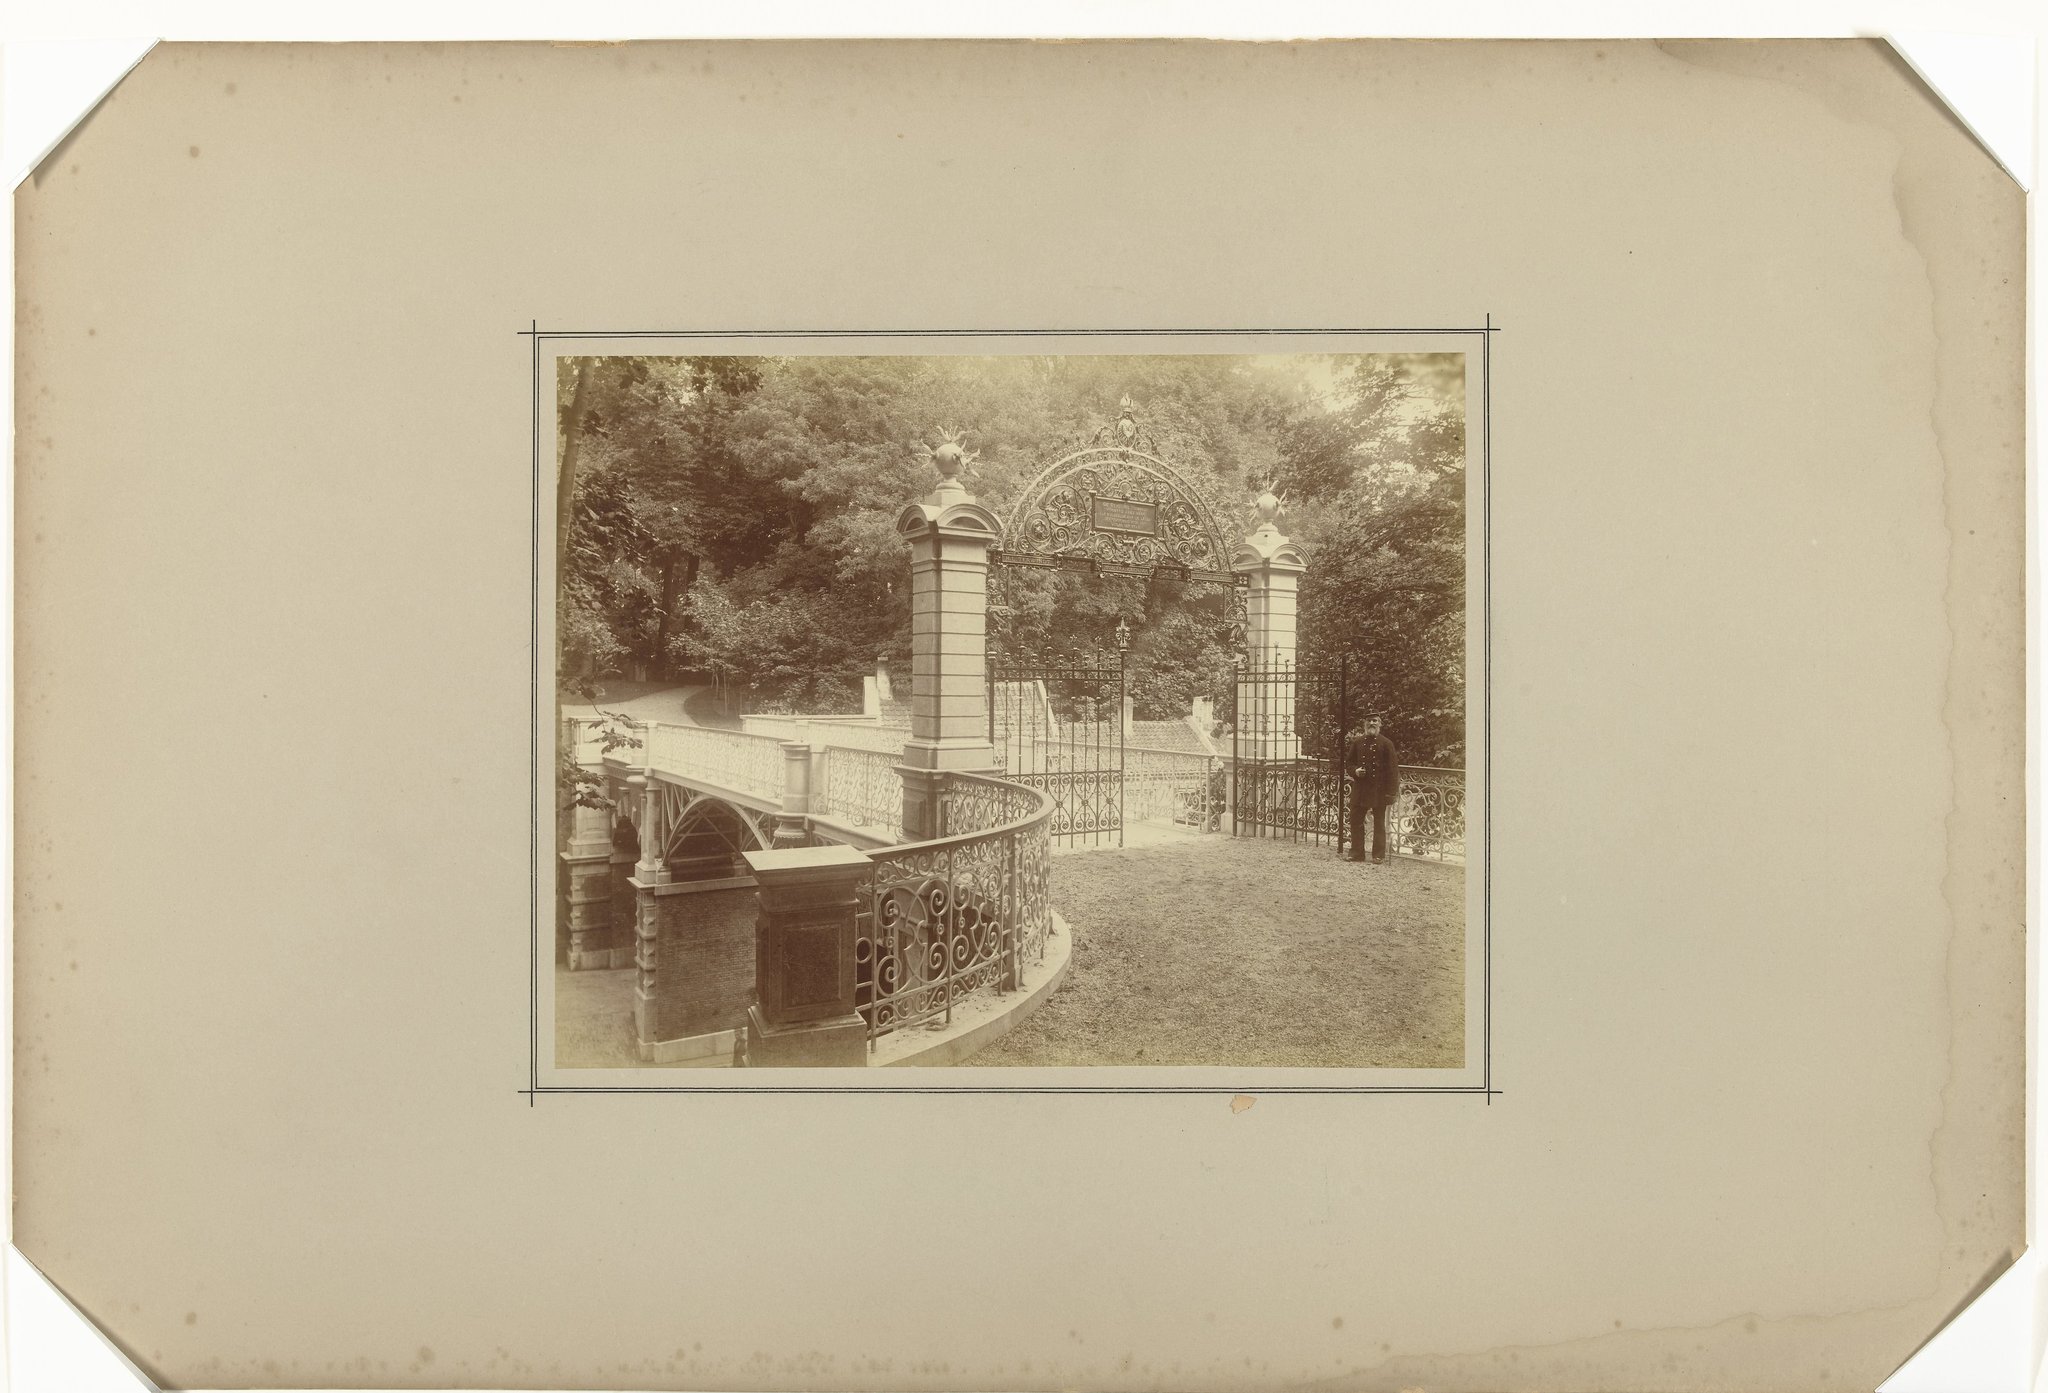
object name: photograph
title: Toegangshek van de Driemansbrug naar het Valkhofpark in Nijmegen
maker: wilhelm ivens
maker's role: fotograaf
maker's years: 1849-1904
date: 1885-1890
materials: cardboard, photographic support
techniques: albumen print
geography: nijmegen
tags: valkhof